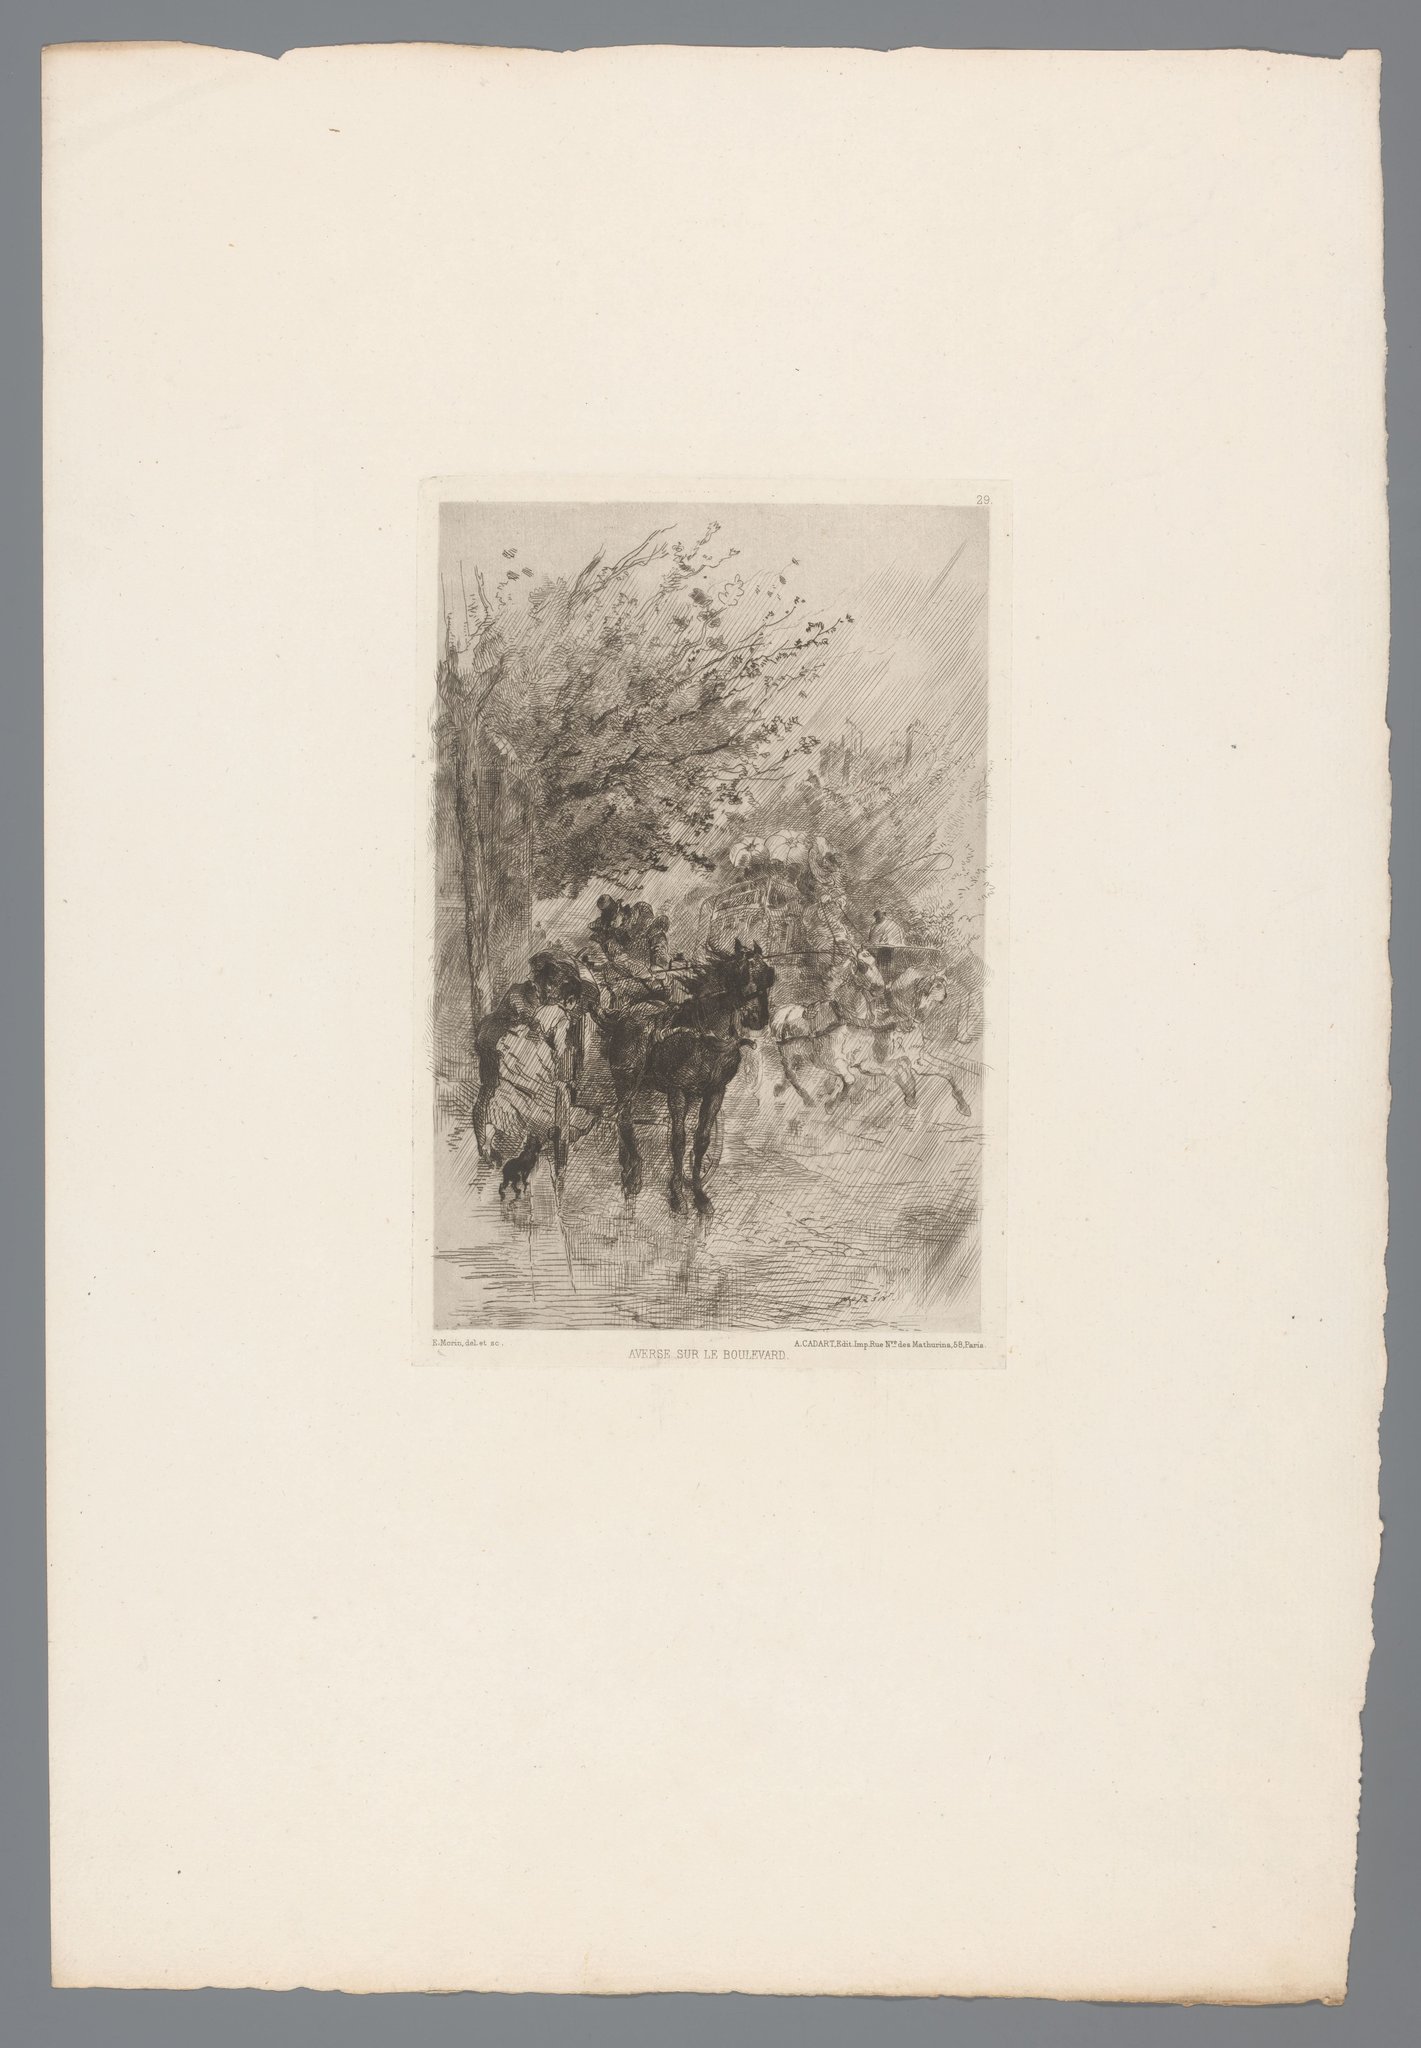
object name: print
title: Paardenkoetsen in regenbui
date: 1874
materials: paper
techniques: drypoint, etching, intaglio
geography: paris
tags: downpour, rain shower, animal traction, animal-drawn vehicle (carriage etc.), horse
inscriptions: collector's mark: ‘AFE v S’, collector's mark: Lugt 2760, collector's mark: Lugt 2228